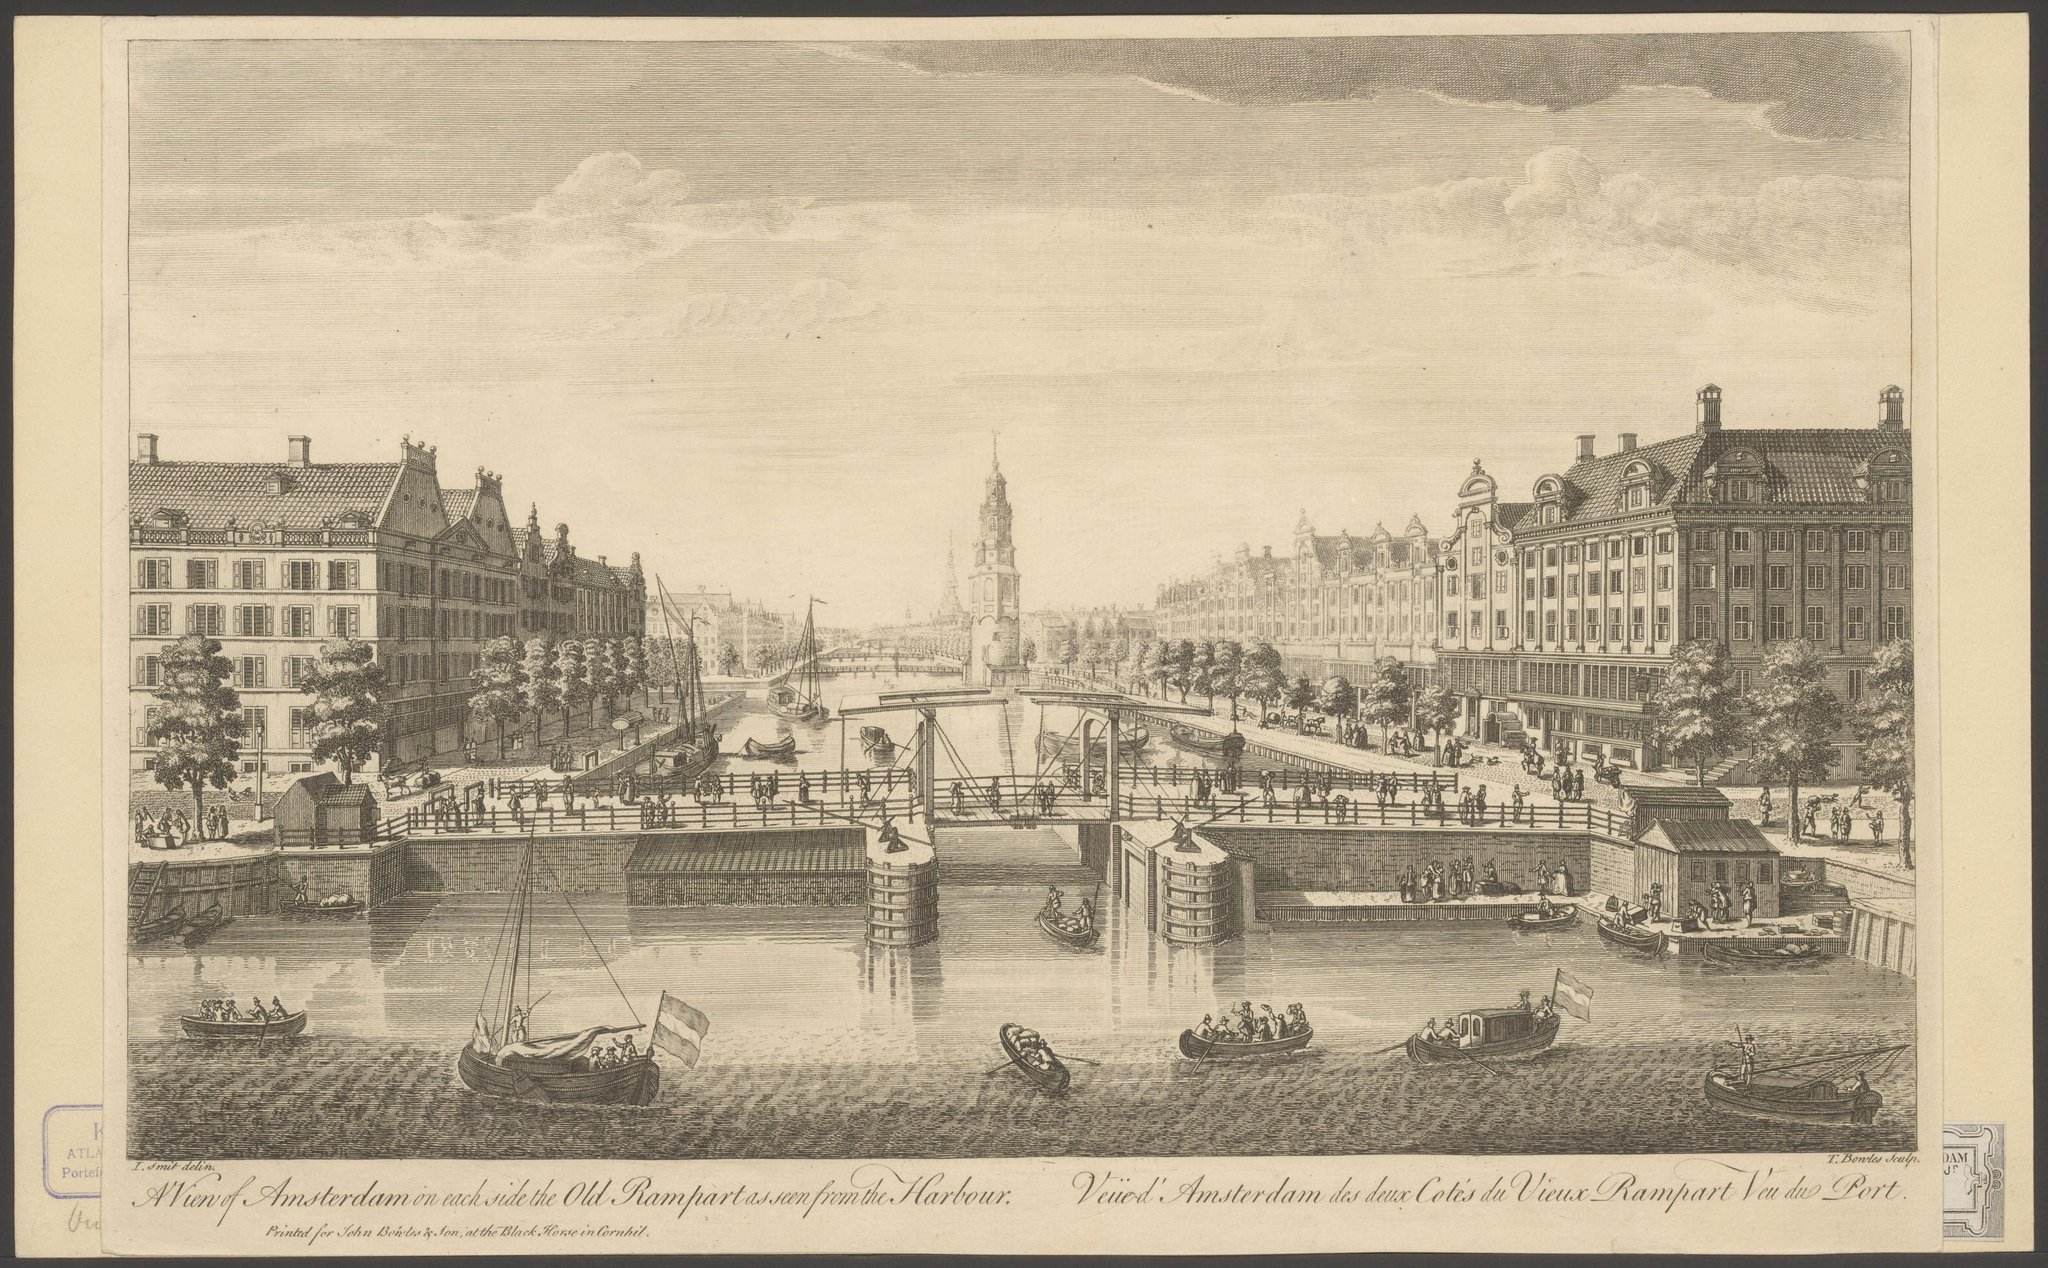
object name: print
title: A View of Amsterdam on each side the Old Rampart as seen from the Harbour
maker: thomas bowles (ii)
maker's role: print maker, publisher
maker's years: 1695-1767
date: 1715-1767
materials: paper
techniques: etching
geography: london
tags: sailing-ship, sailing-boat, tower, clock tower ~ monumental adornment, city-view in general; 'veduta', river, bridge in city across river, canal, etc., boat propelled by man or animal, amsterdam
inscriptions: collector's mark: ‘13,3’ Lugt 1641b, : ‘Atlas van Amsterdam / van D.C. Meijer Jr. / 318’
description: Onderwerpsrubriek binnen de Atlas Amsterdam: Oude Schans, Schoutensteeg, Singel (Korte), Singel.